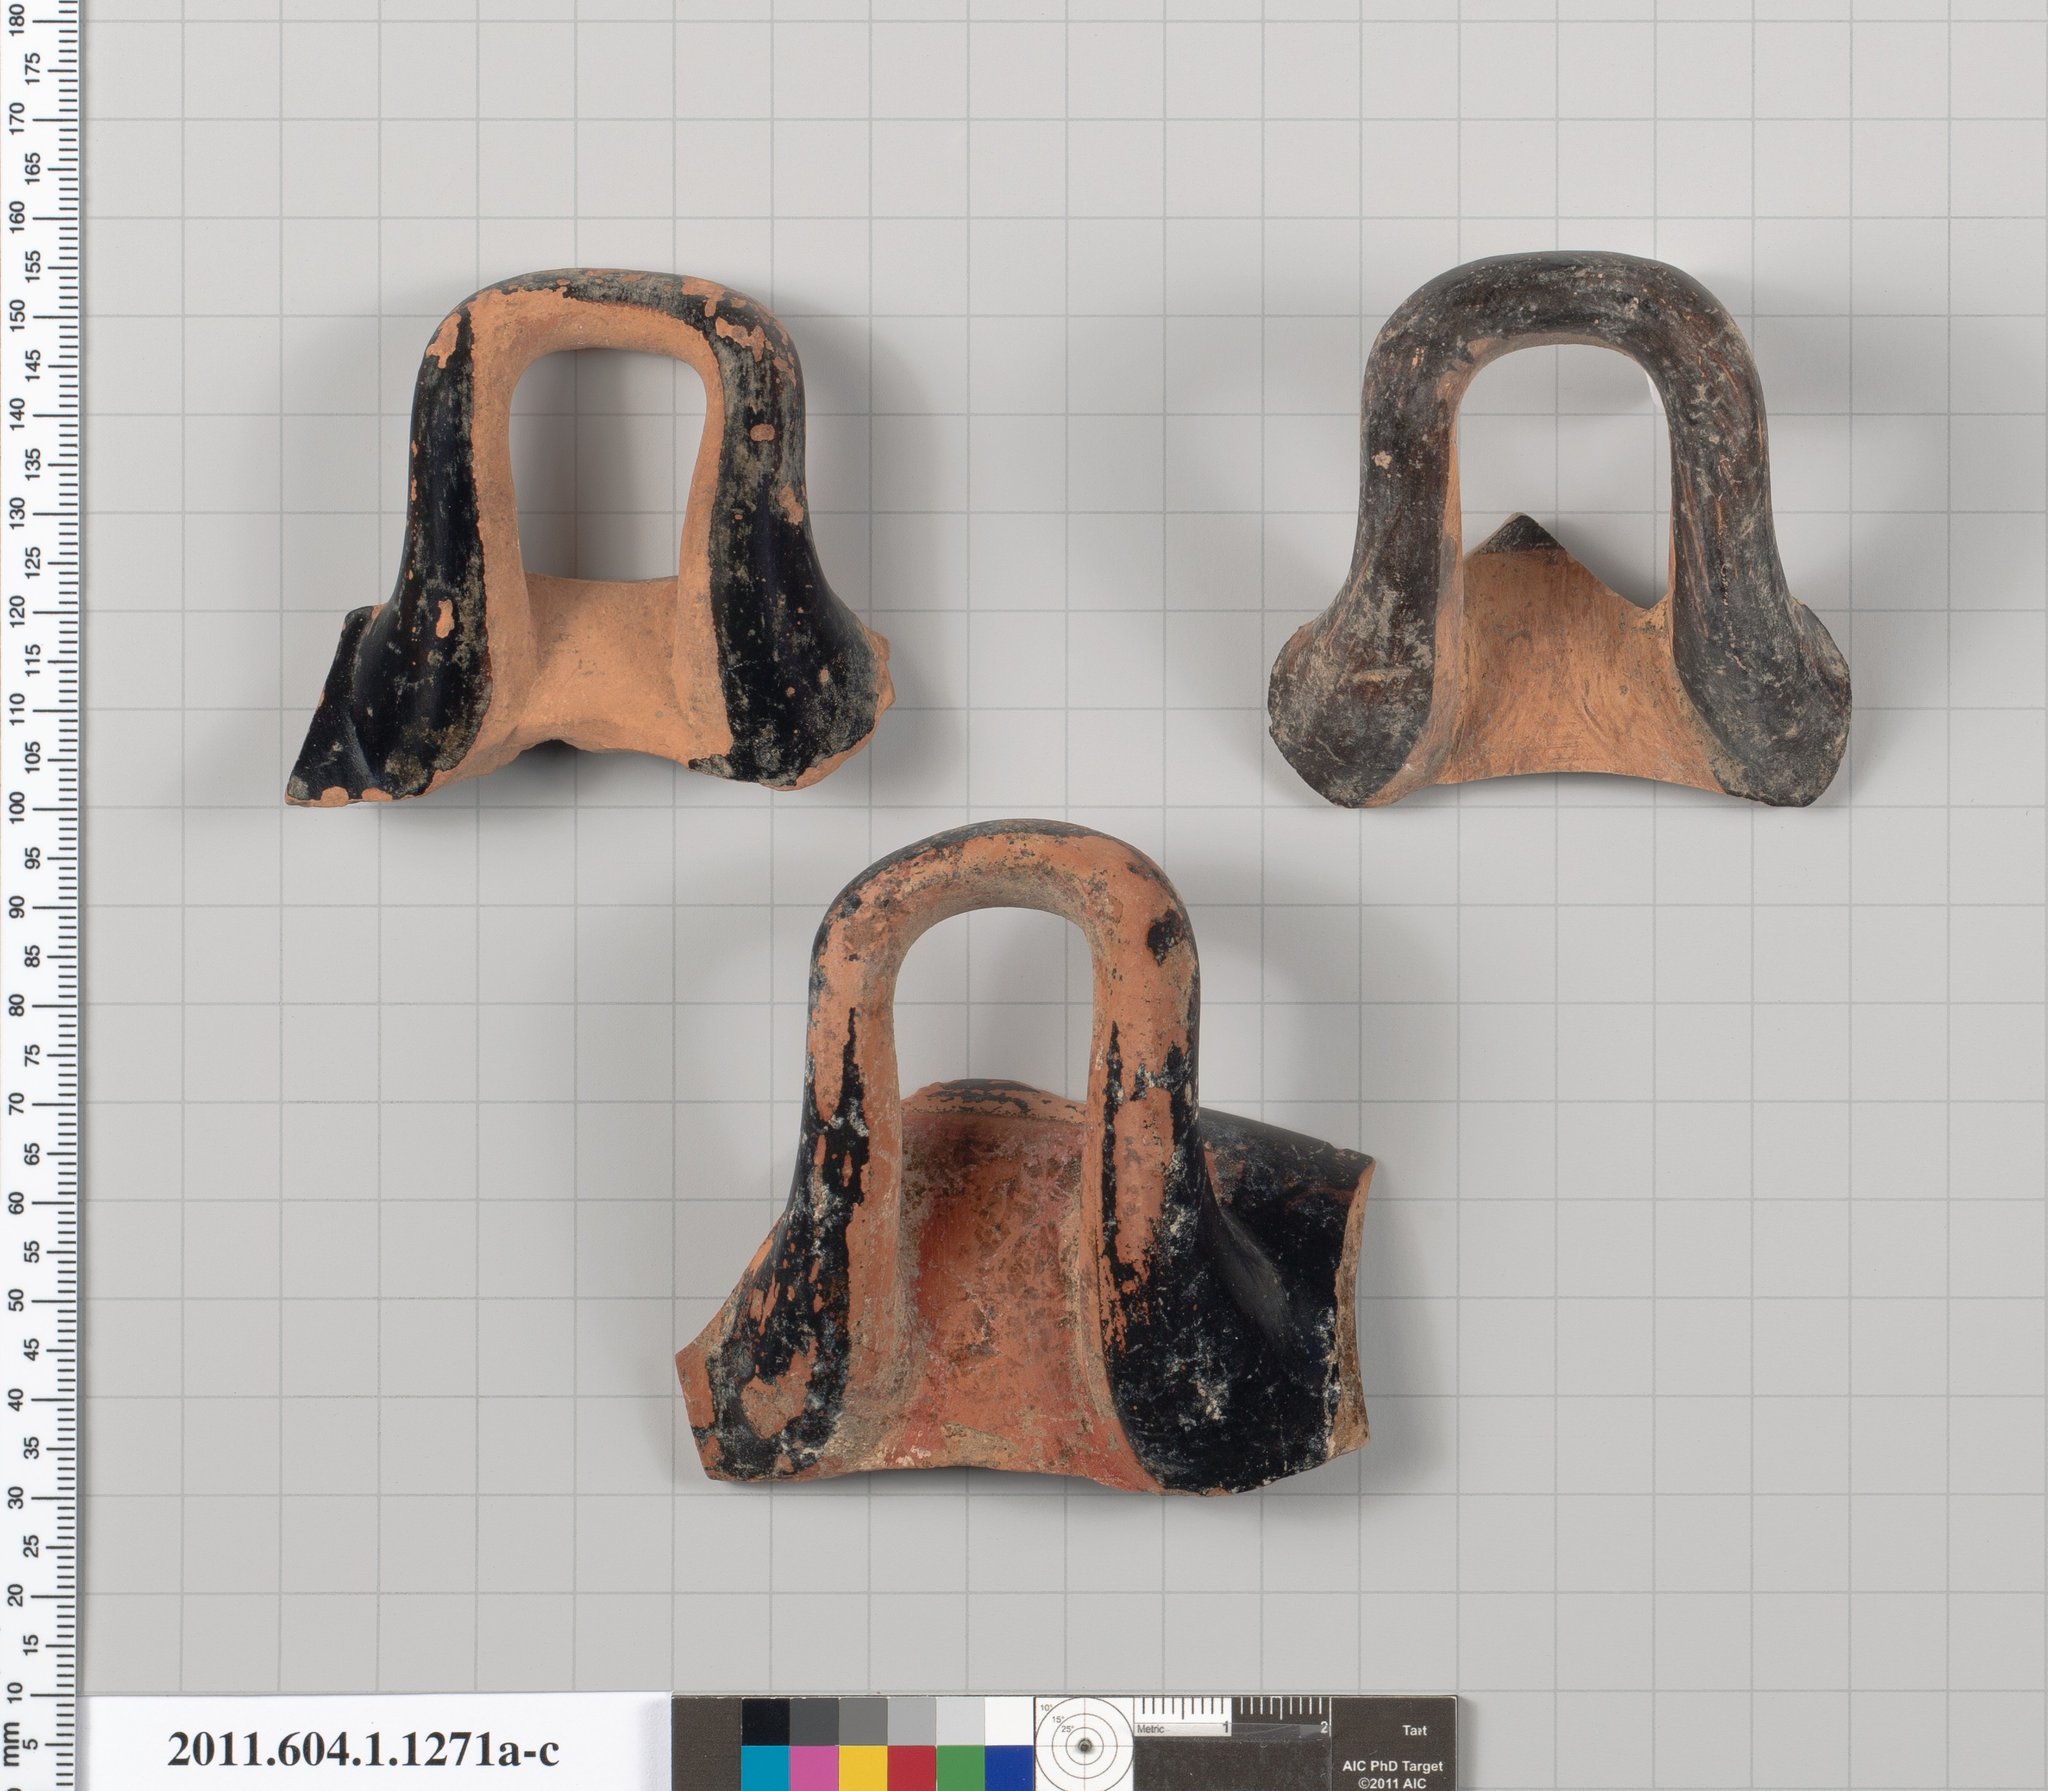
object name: kylix fragment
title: Terracotta fragments of kylikes (drinking cups)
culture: greek, attic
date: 500-401 BCE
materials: terracotta